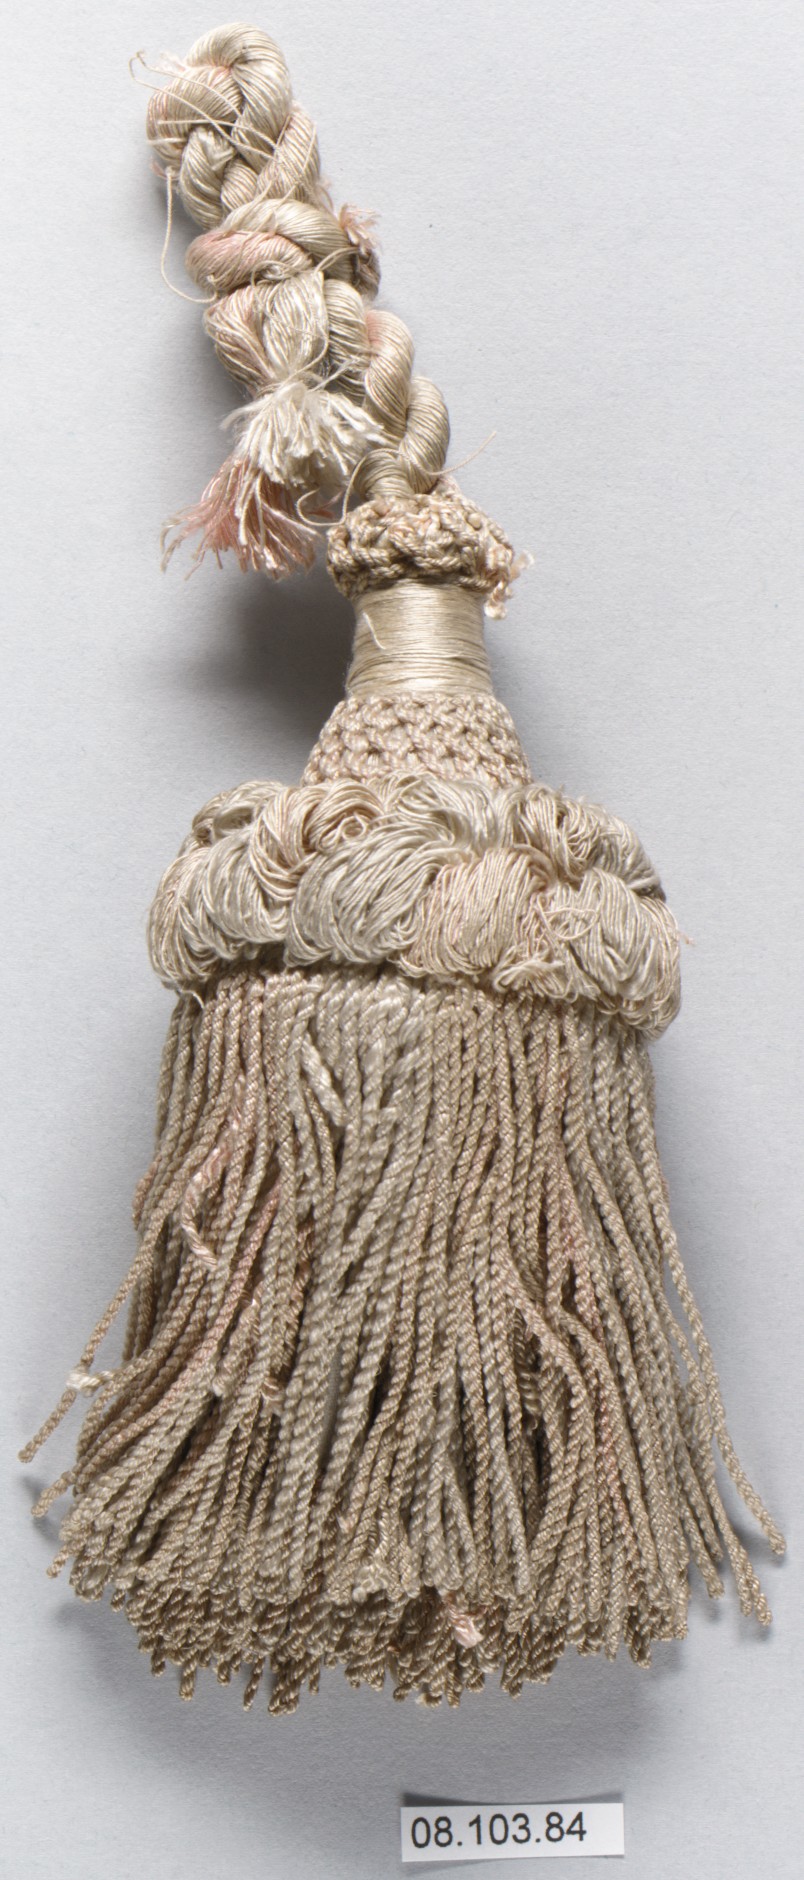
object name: tassel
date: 1701-1800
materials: silk